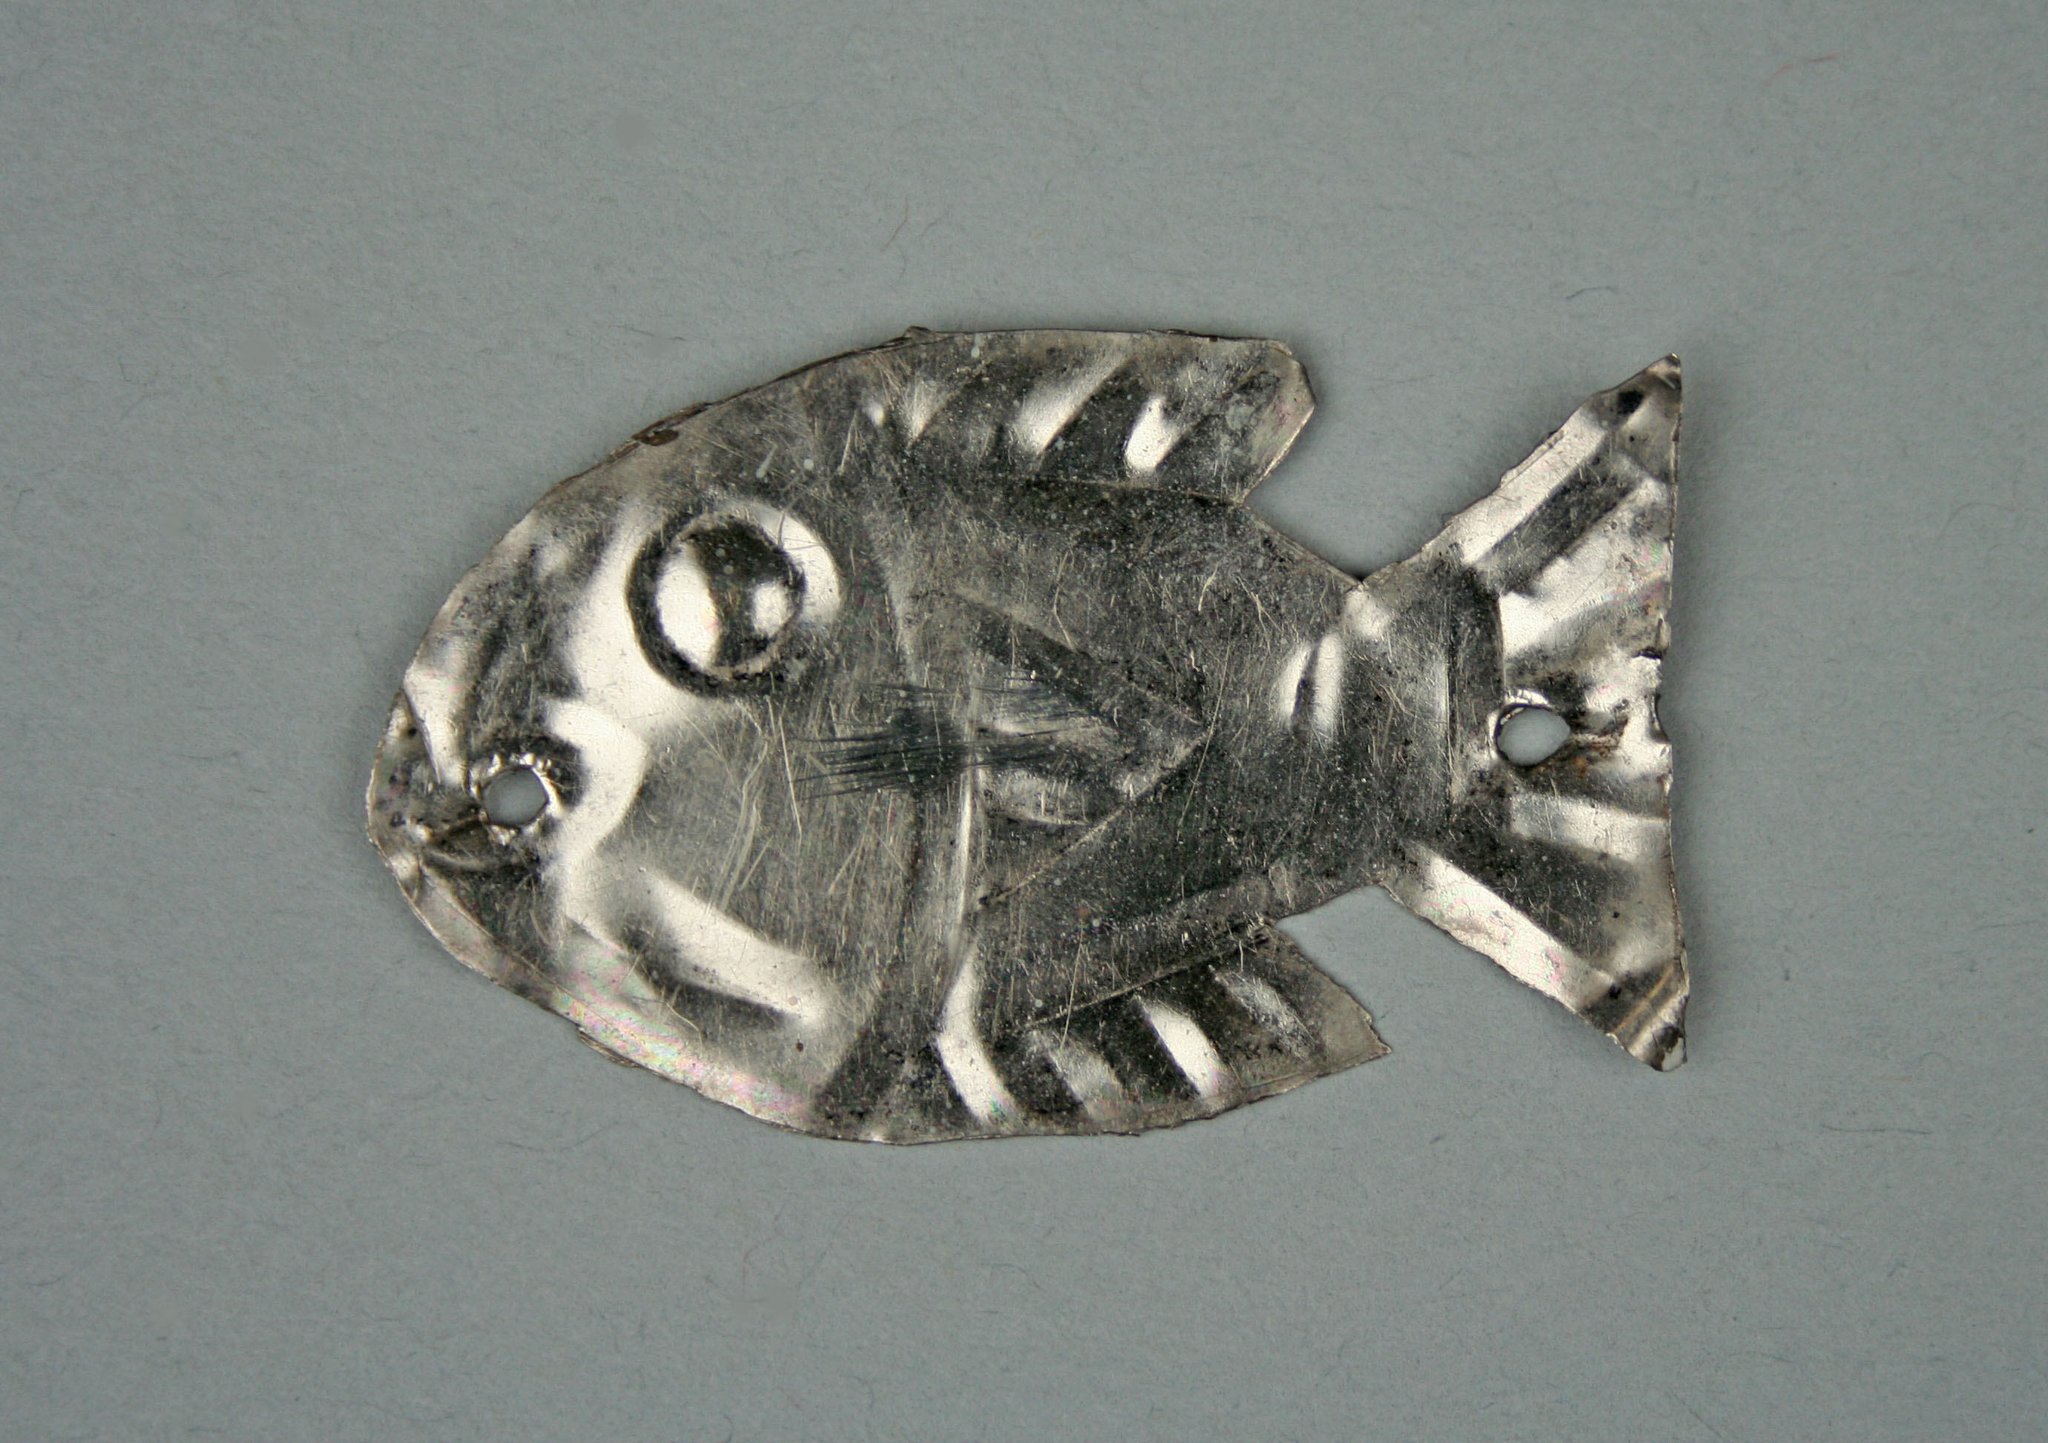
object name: ornament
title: Fish Ornament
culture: peruvian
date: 1001-1200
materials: silver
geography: peru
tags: fish